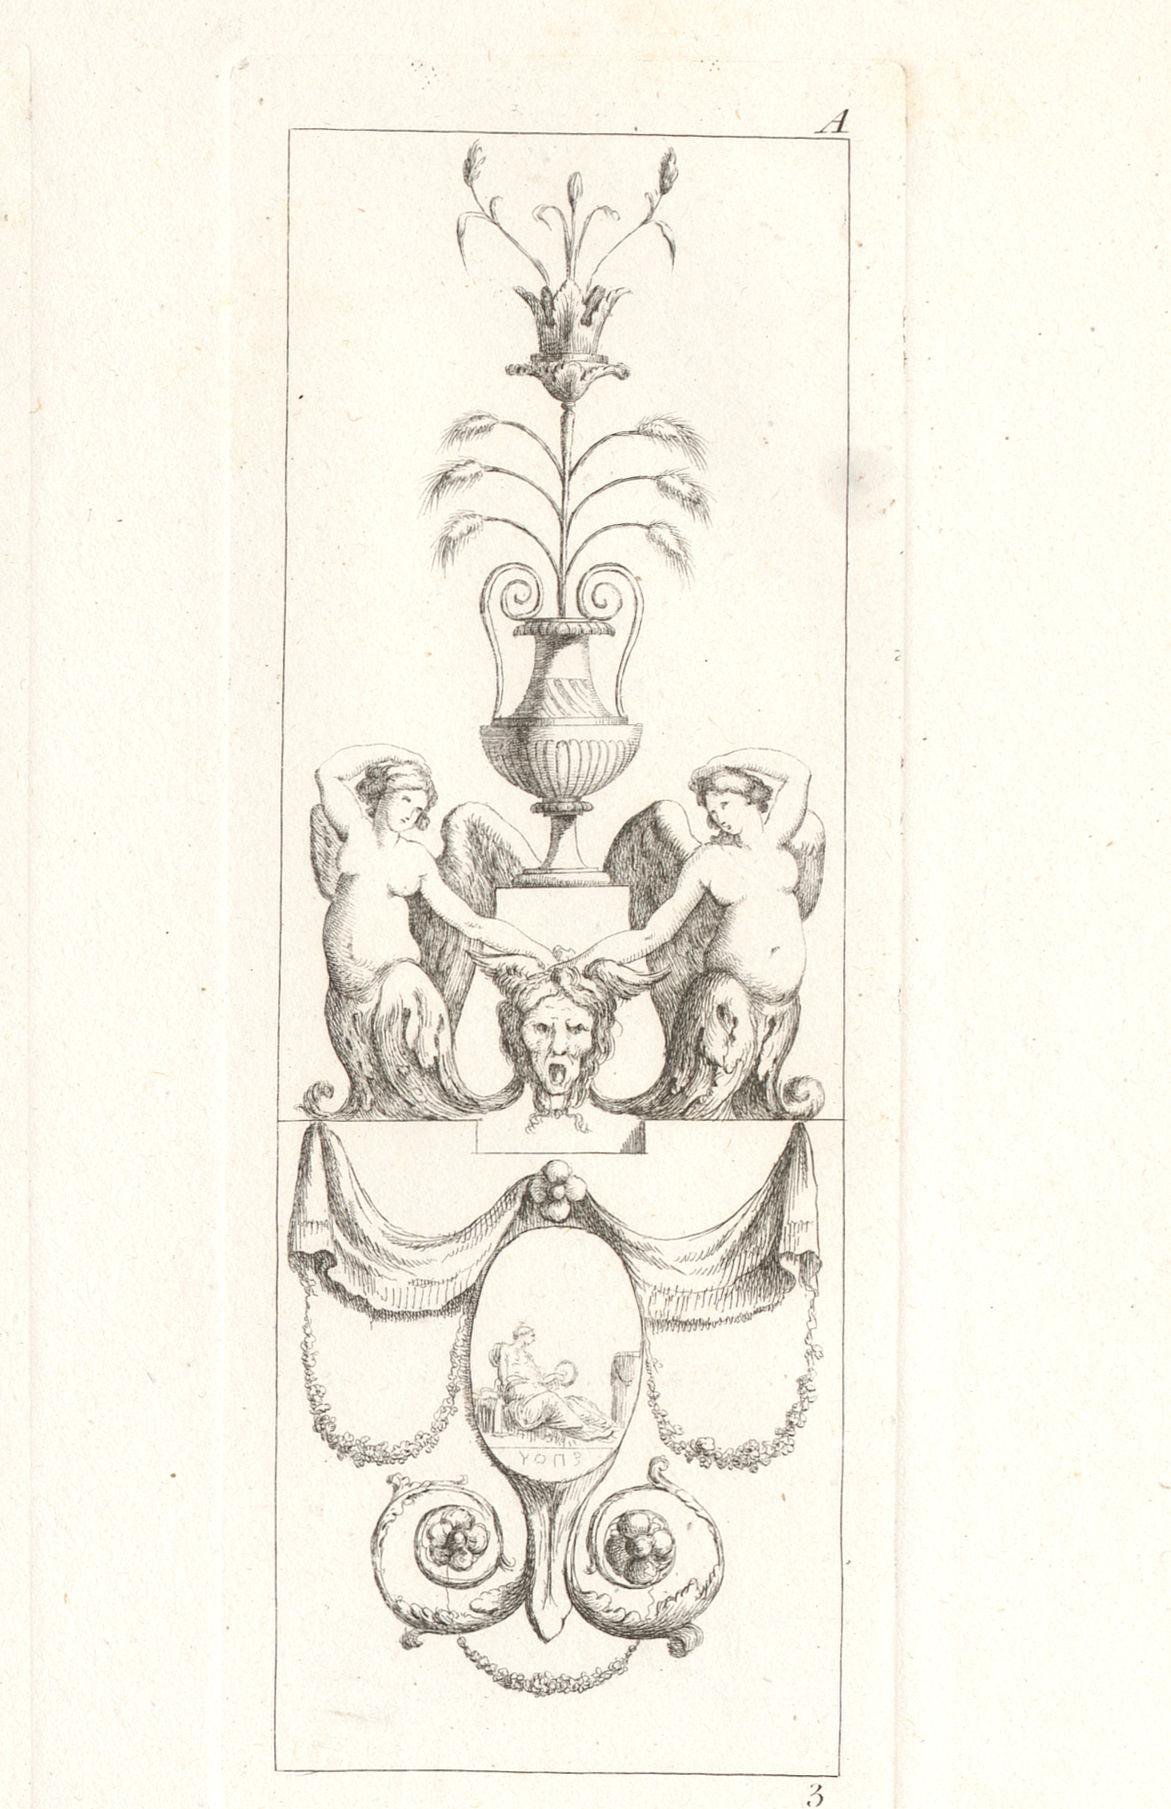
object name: ornament print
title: Recueil d'arabesques, contenant les loges du Vatican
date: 1802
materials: paper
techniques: etching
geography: paris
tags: fabulous beings with wings - aa - female human figure, ornament ~ arabesque, mask, mascaron ~ ornament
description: Doordat dit album bestaat uit meerdere, deels eerder uitgegeven prentreeksen, is de datering niet consequent. Het geheel is op de titelpagina gedateerd op 1802. Deze reeks is niet los gedateerd. De serietitel voor het gehele werk is "Recueil d'arabesques, contenant les loges du Vatican". De andere serietitel is de titel van de specifieke reeks binnen het geheel.